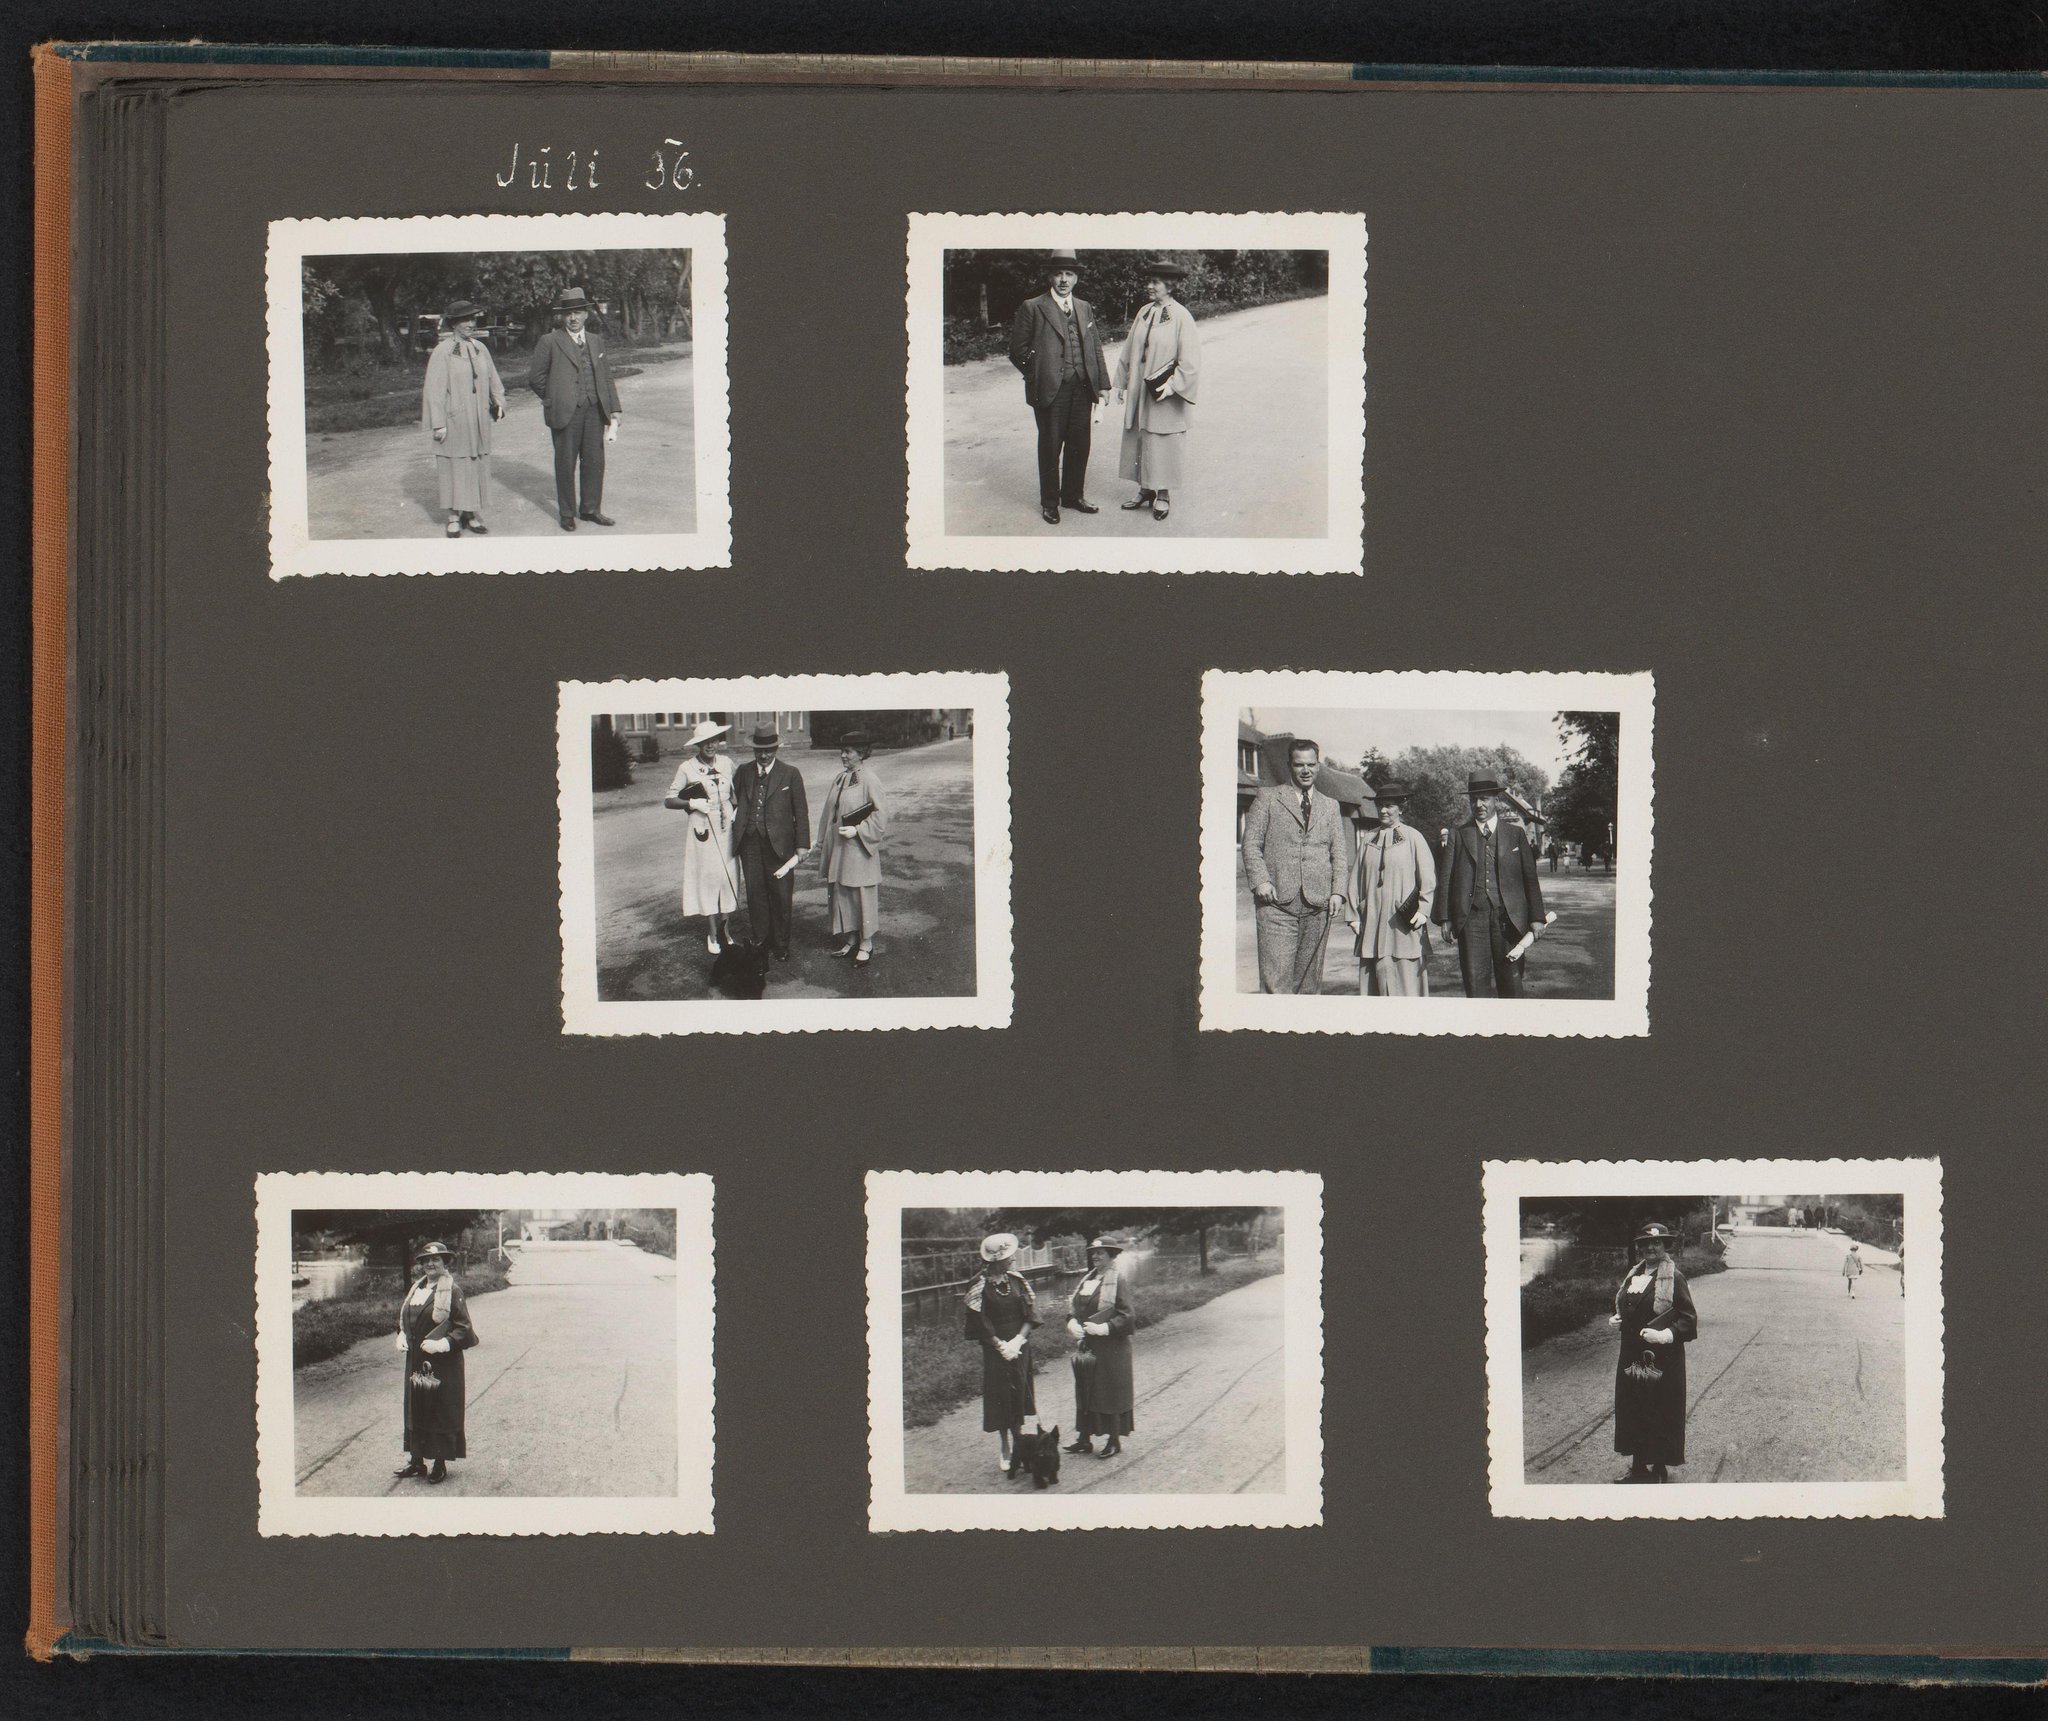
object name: photograph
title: Echtpaar Berti Hoppe en Herman Besselaar met kennissen tijdens een dag uit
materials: cardboard, paper, photographic support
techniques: gelatin silver print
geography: rotterdam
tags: herman besselaar, berti hoppe, historical persons - bb - woman, historical persons, street (+ city(-scape) with figures, staffage), rotterdam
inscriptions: date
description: Zeven foto's gemaakt op een dag in juli 1936. Deze pagina maakt deel uit van een album.